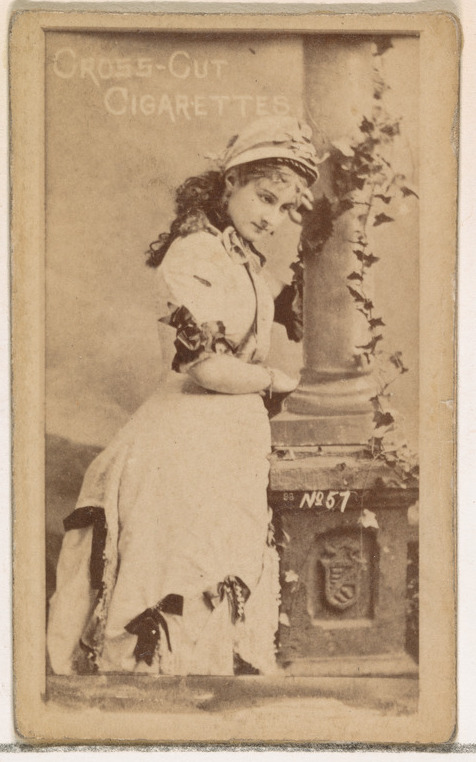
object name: print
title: Card Number 57, from the Actors and Actresses series (N145-1) issued by Duke Sons & Co. to promote Cross Cut Cigarettes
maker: w. duke, sons & co.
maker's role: publisher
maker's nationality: american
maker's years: 1870-1920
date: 1880-1889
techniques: albumen silver print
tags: portraits,women,actresses